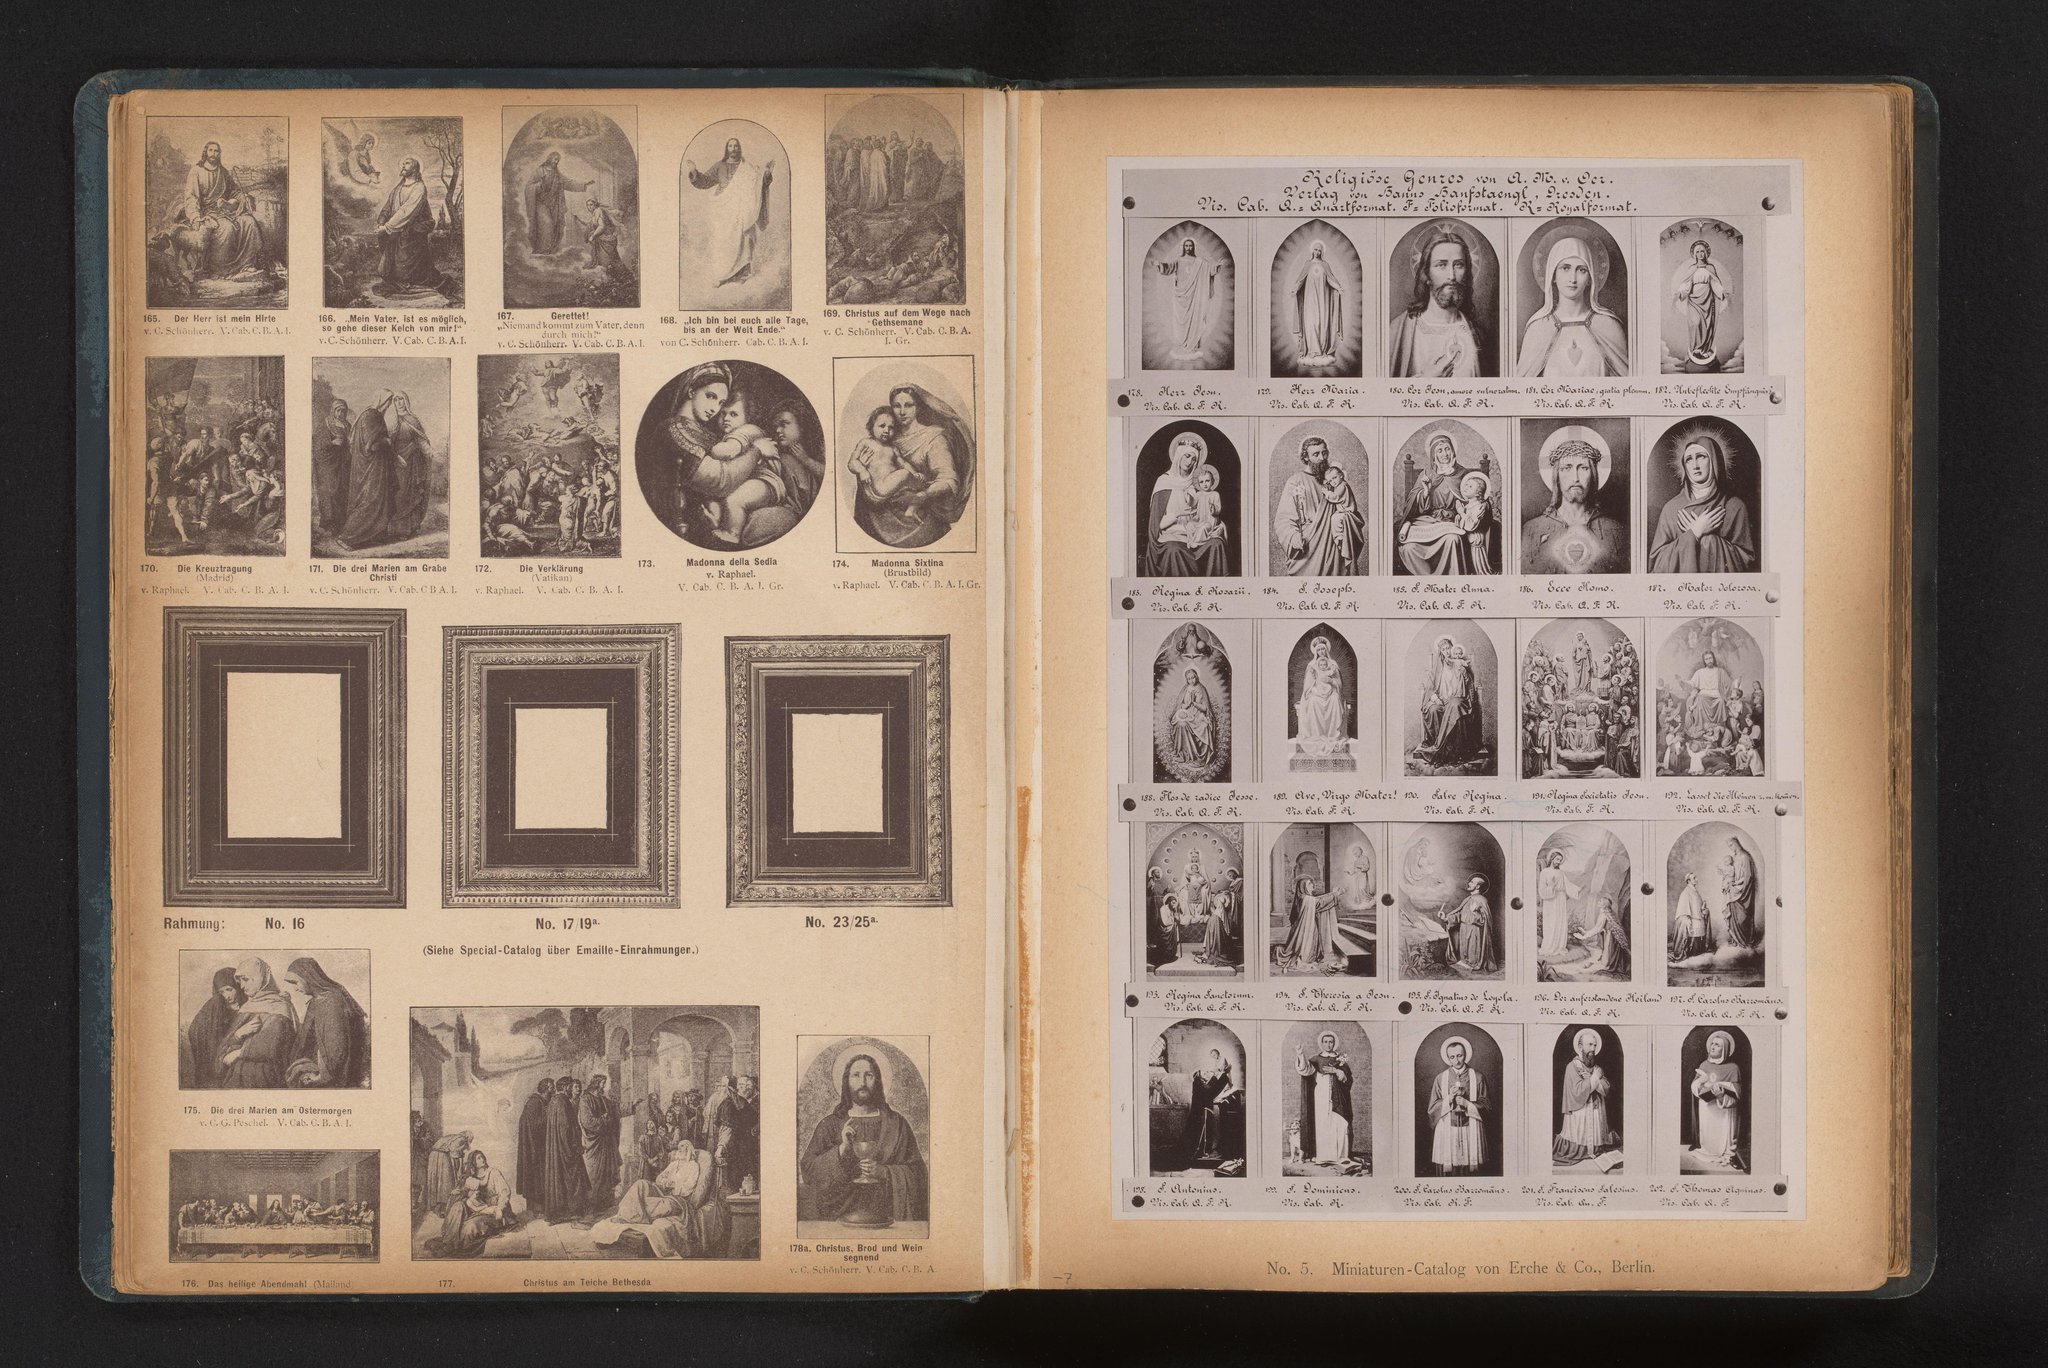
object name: reproduction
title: Fotoreproducties van 25 geschilderde portretten van heiligen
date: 1880-1885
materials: paper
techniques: photograph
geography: berlin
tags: saints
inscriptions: number: ‘No. 5.’